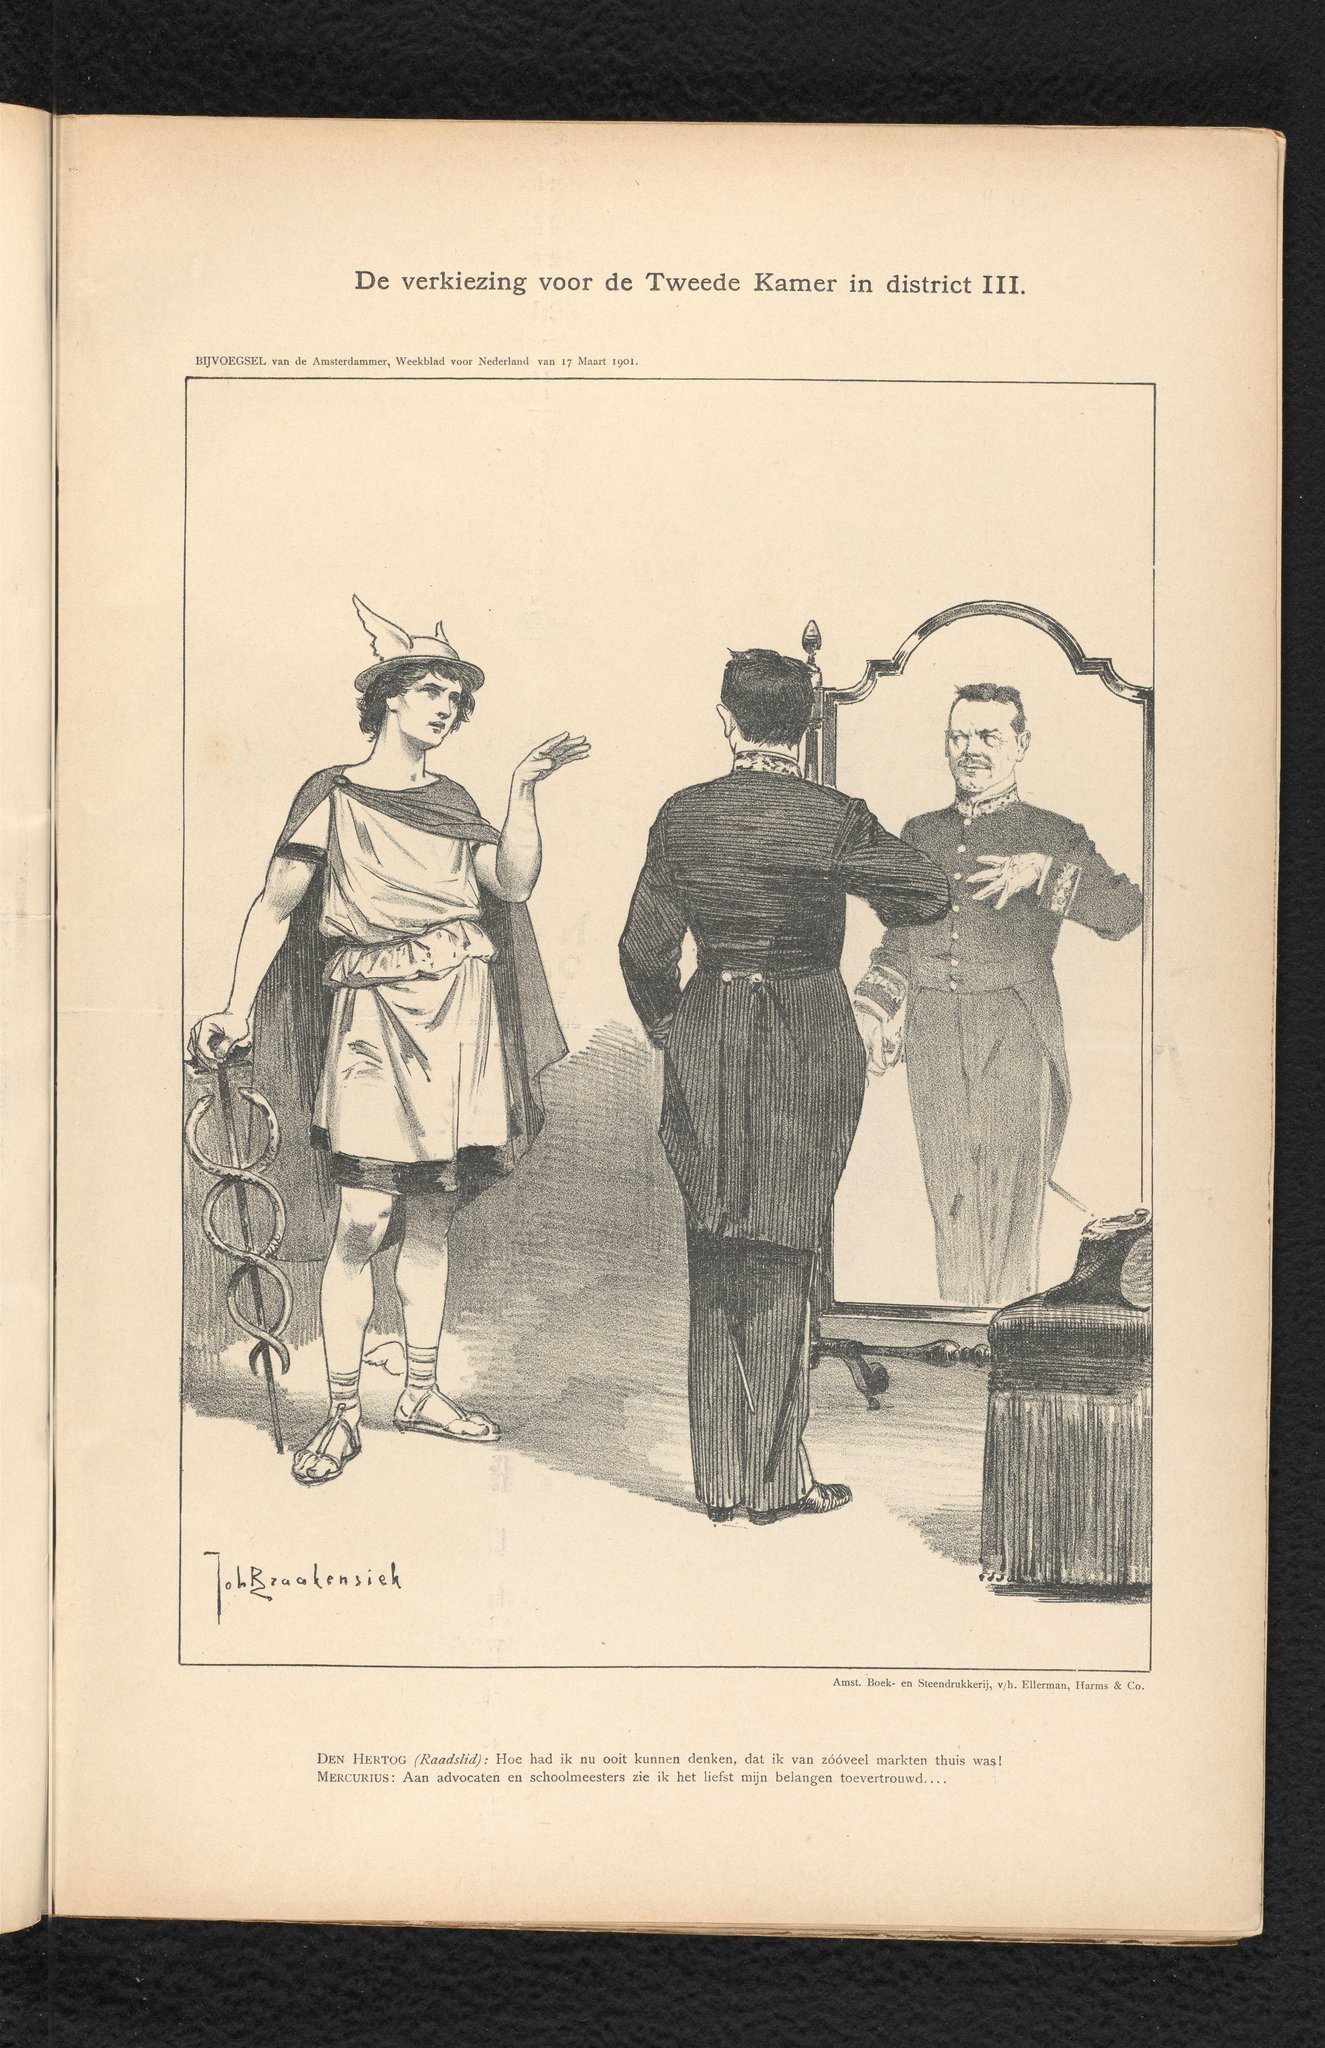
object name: cartoon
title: De verkiezing voor de Tweede Kamer in district III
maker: johan braakensiek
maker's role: draughtsman, print maker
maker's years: 1858-1940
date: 1901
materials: paper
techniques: lithograph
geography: netherlands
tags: the hague, amsterdam, looking in the mirror; contemplation of own beauty, specific aspects, allegorical aspects of mercury; mercury as patron, political caricatures and satires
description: Amsterdamse raadslid Cornelis den Hertog zichzelf bewonderend voor de spiegel, wordt sarcastisch toegesproken door Mercurius. In 1901 versloeg Den Hertog bij verkiezingen in het 'rode' district Amsterdam III Henri Polak.